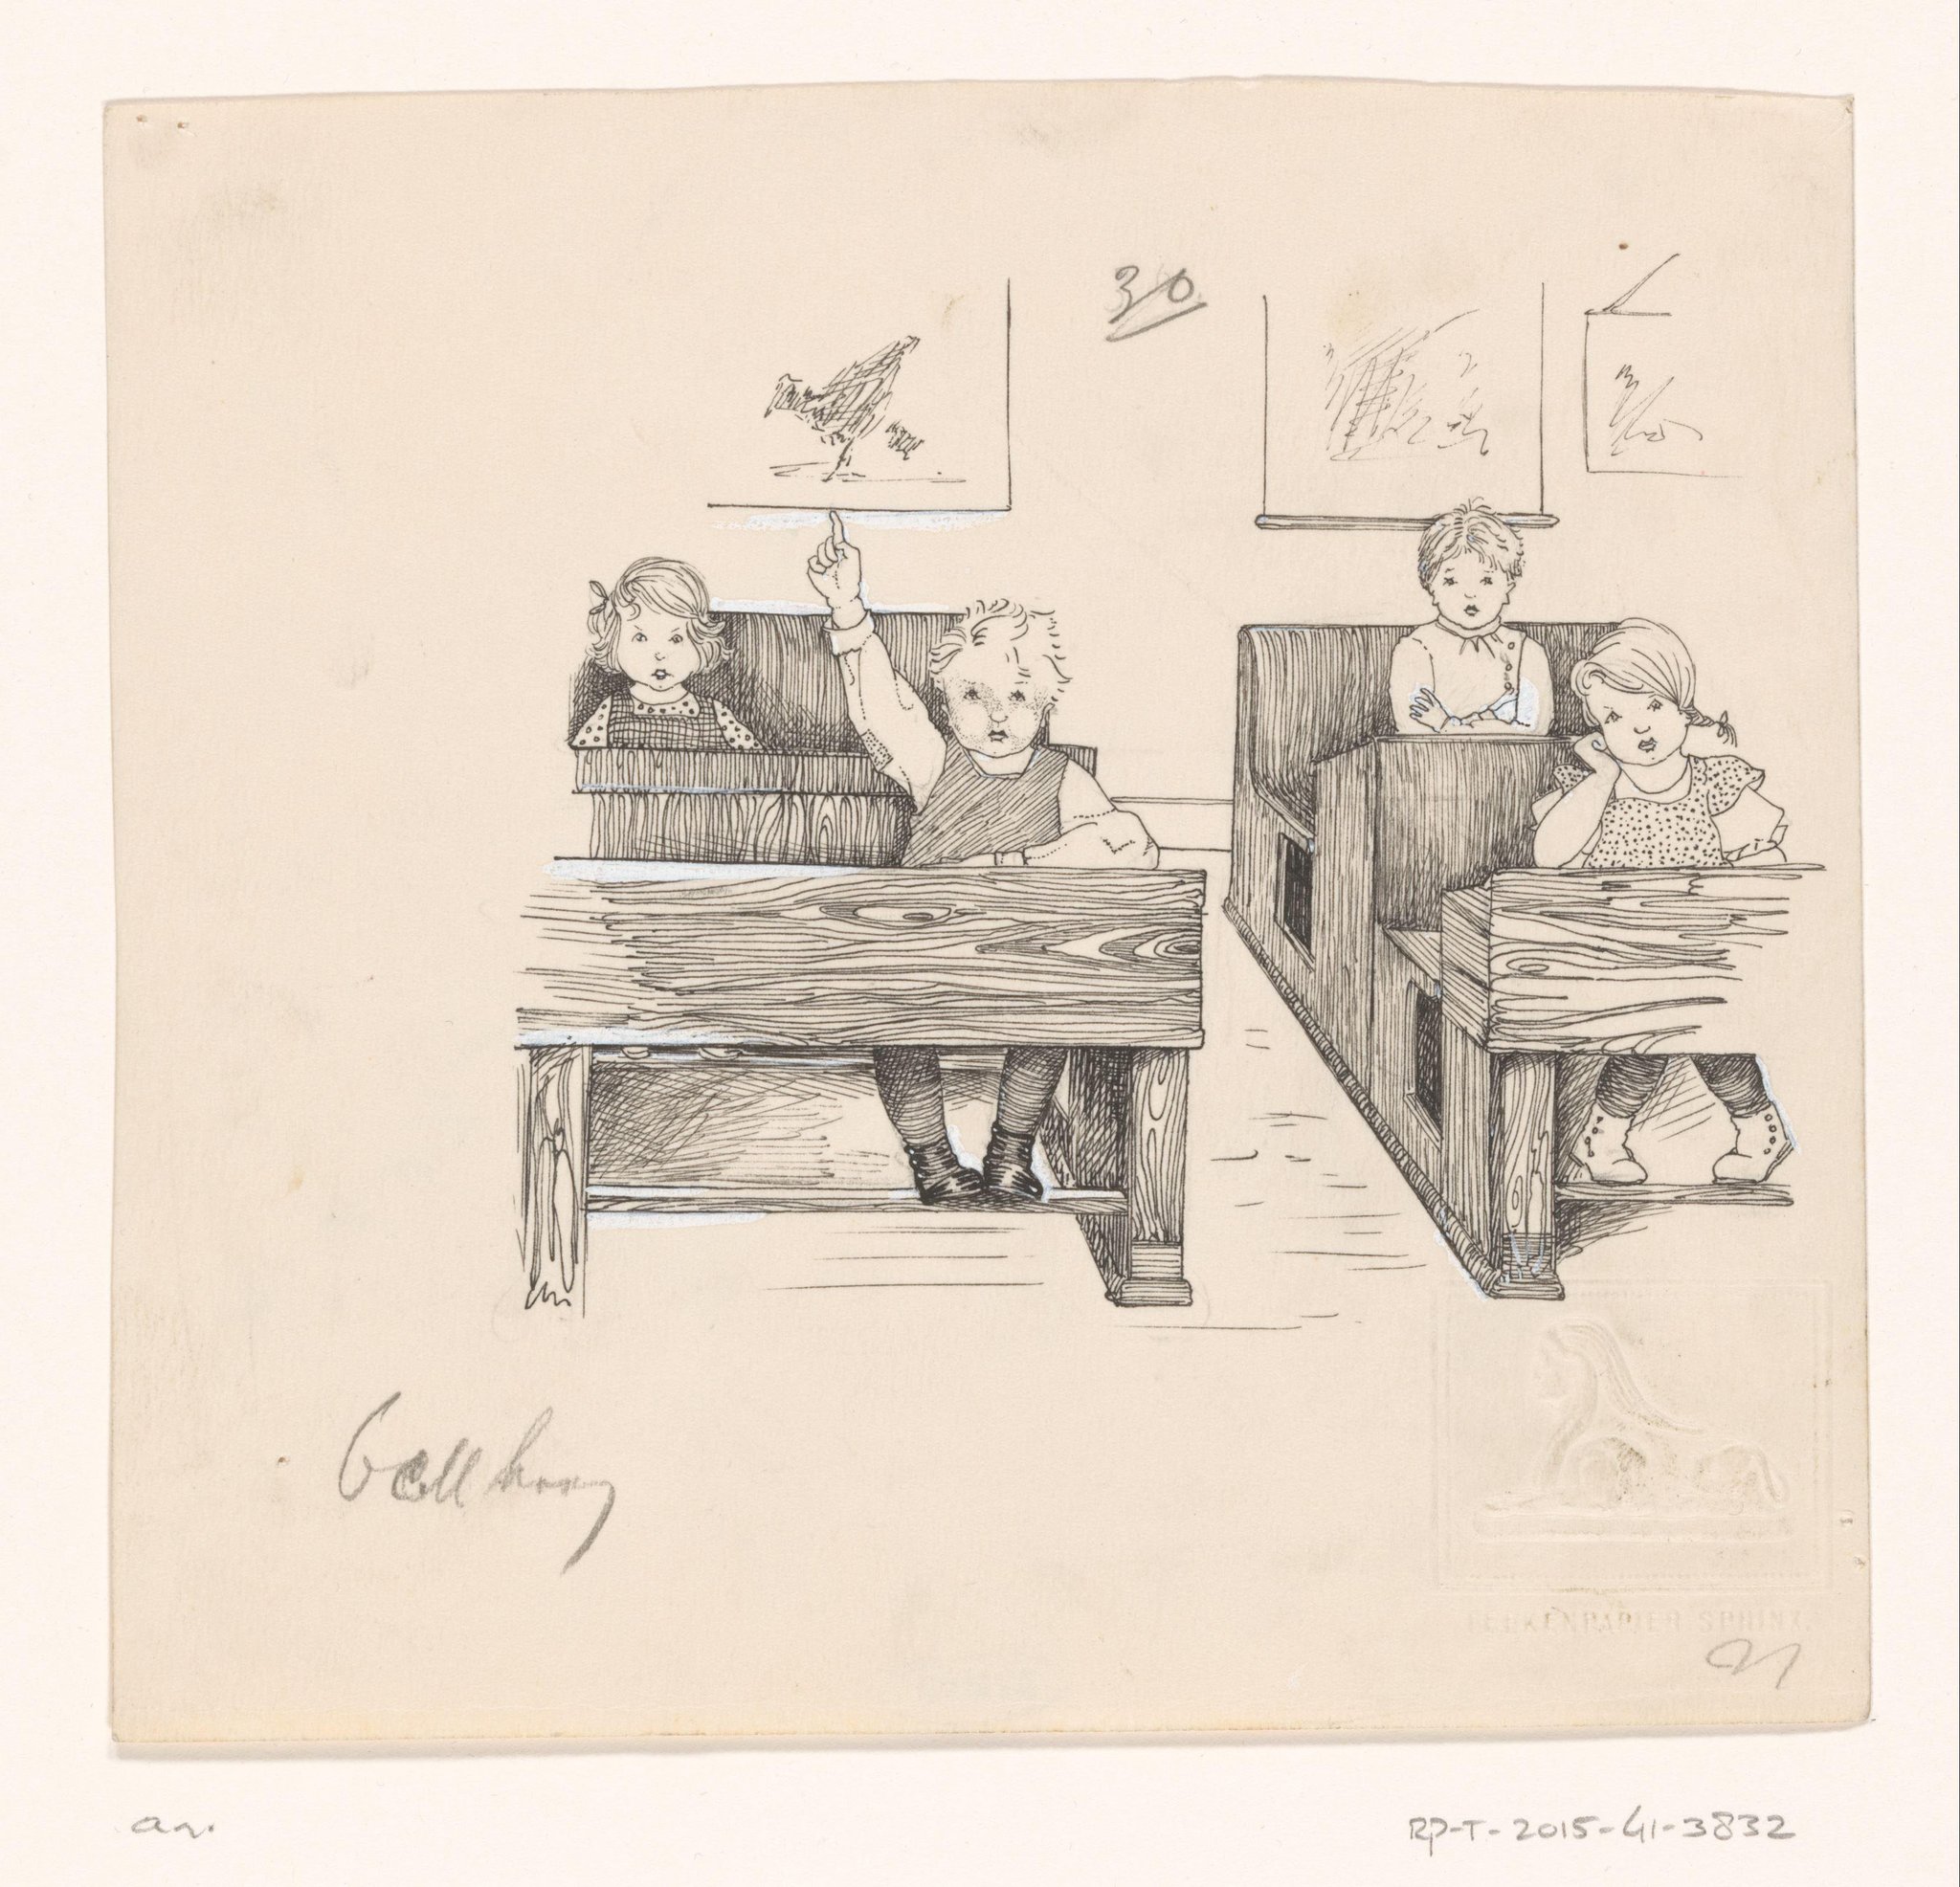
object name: boekillustratie ontwerp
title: Kinderen in de schoolbanken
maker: Anonymous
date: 1890-1930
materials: paint, ink, paper, pencil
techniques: brush, pen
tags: index finger upwards, elementary school; class, form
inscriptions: collector's mark: Lugt 2228a, :, number: ‘30.’, factory mark: ‘TEEKENPAPIER SPHINX.’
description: Een kind op de voorste rij steekt een vinger in de lucht.